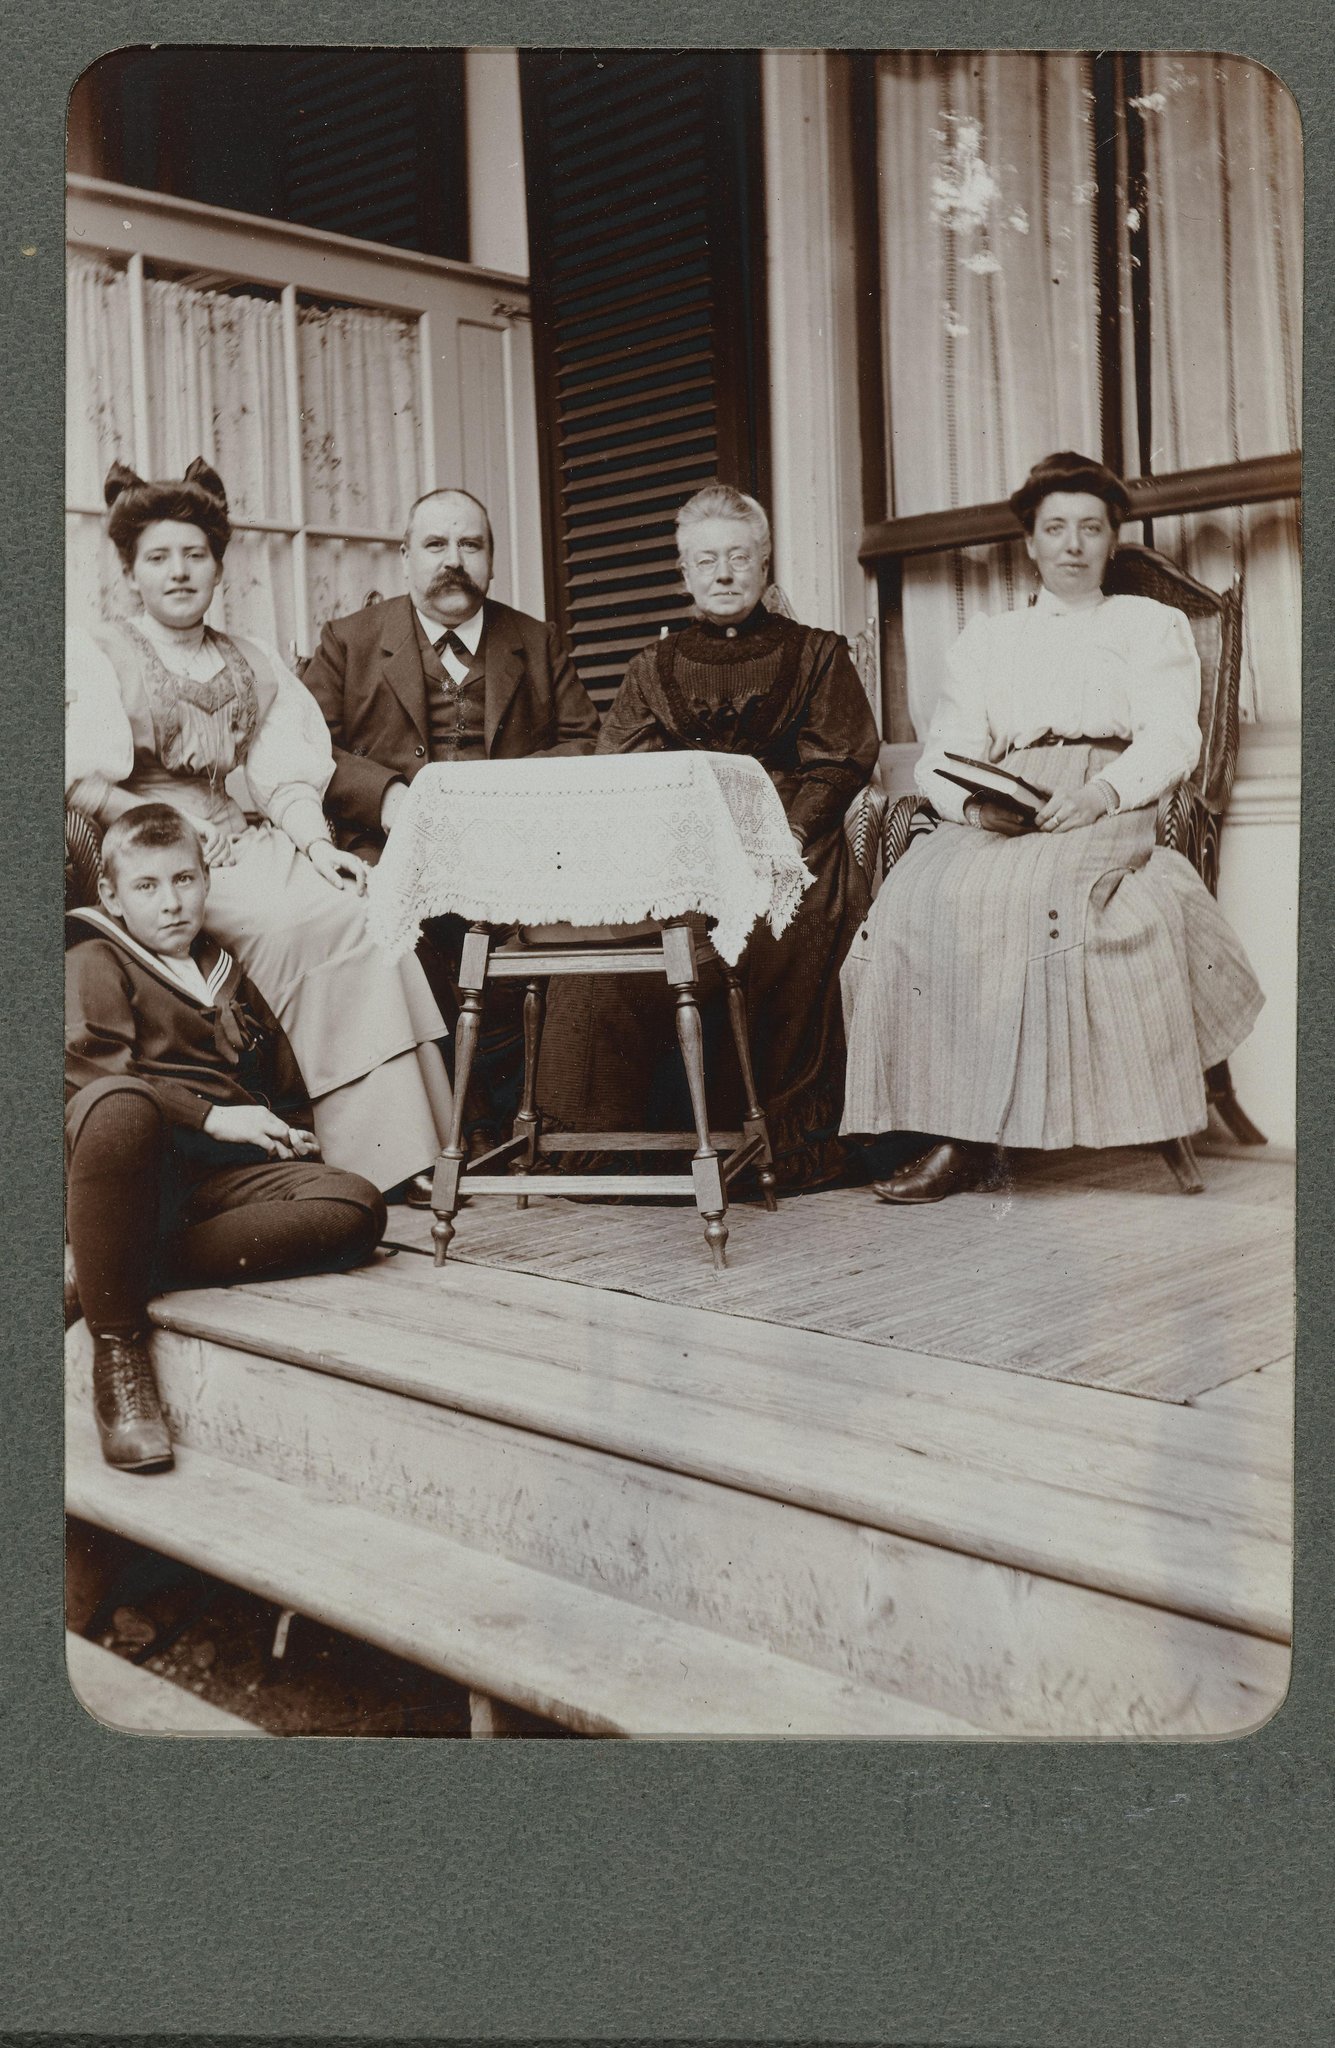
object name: album leaf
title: Groepsportret van een familie, zittend op een veranda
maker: christiaan otto roelofs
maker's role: fotograaf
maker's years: 1882-1970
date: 1900-1915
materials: photographic support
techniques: gelatin silver print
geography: netherlands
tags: family group, especially parents with their child(ren), historical persons